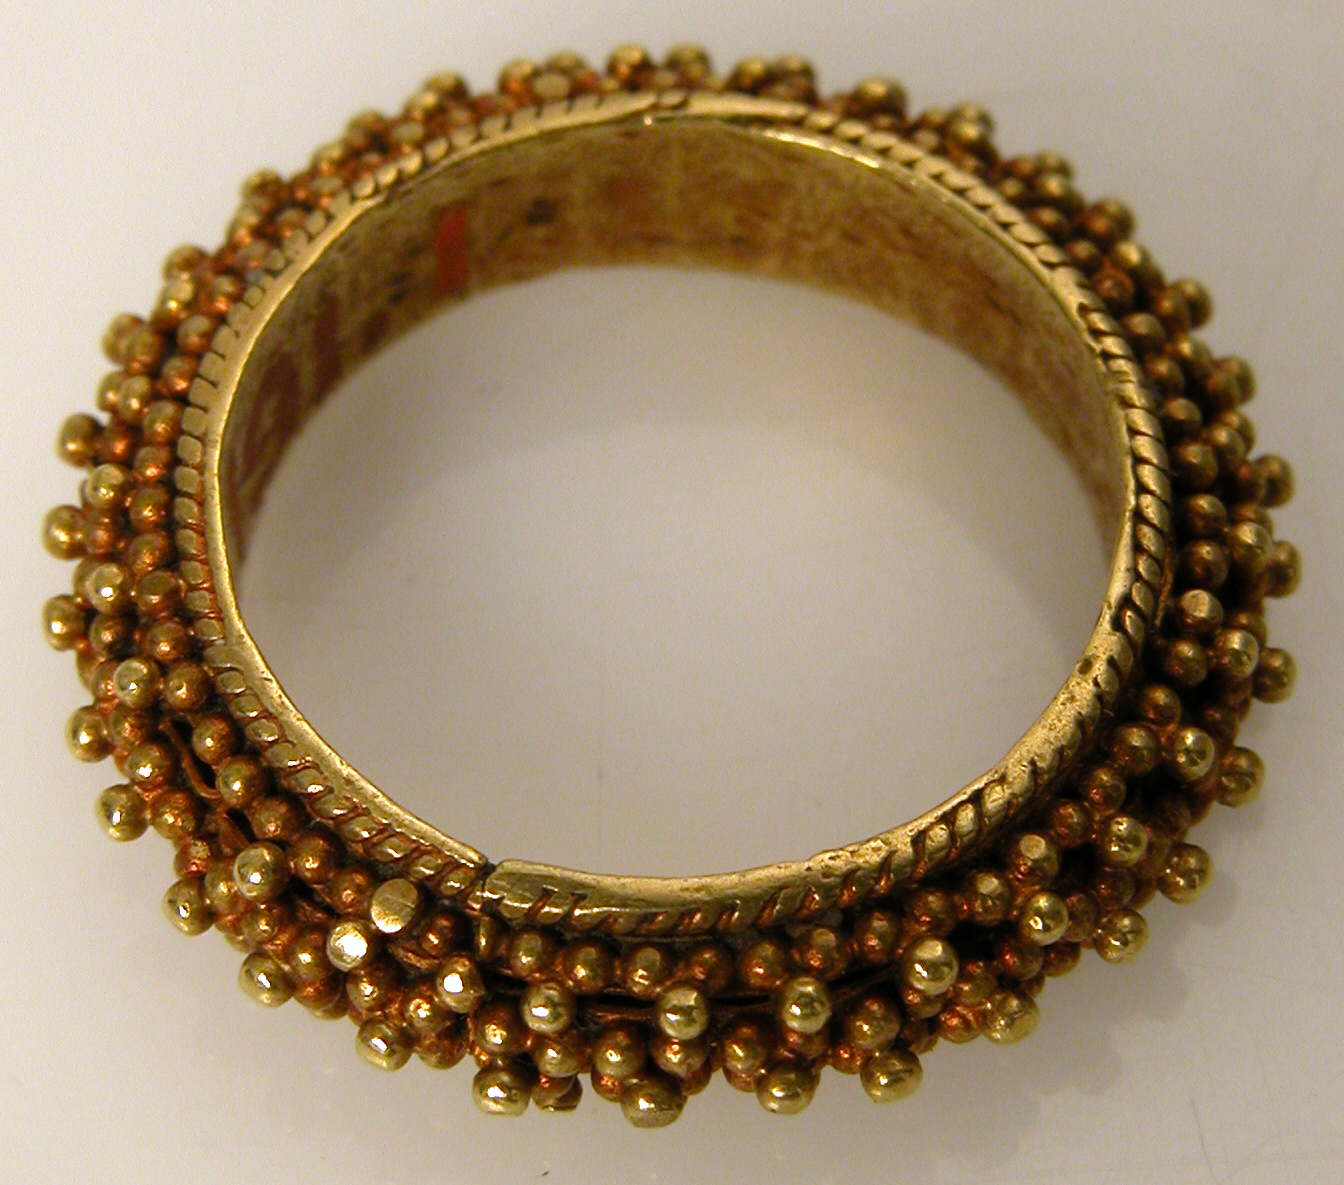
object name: ring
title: Finger Ring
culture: byzantine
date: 901-1000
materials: gold